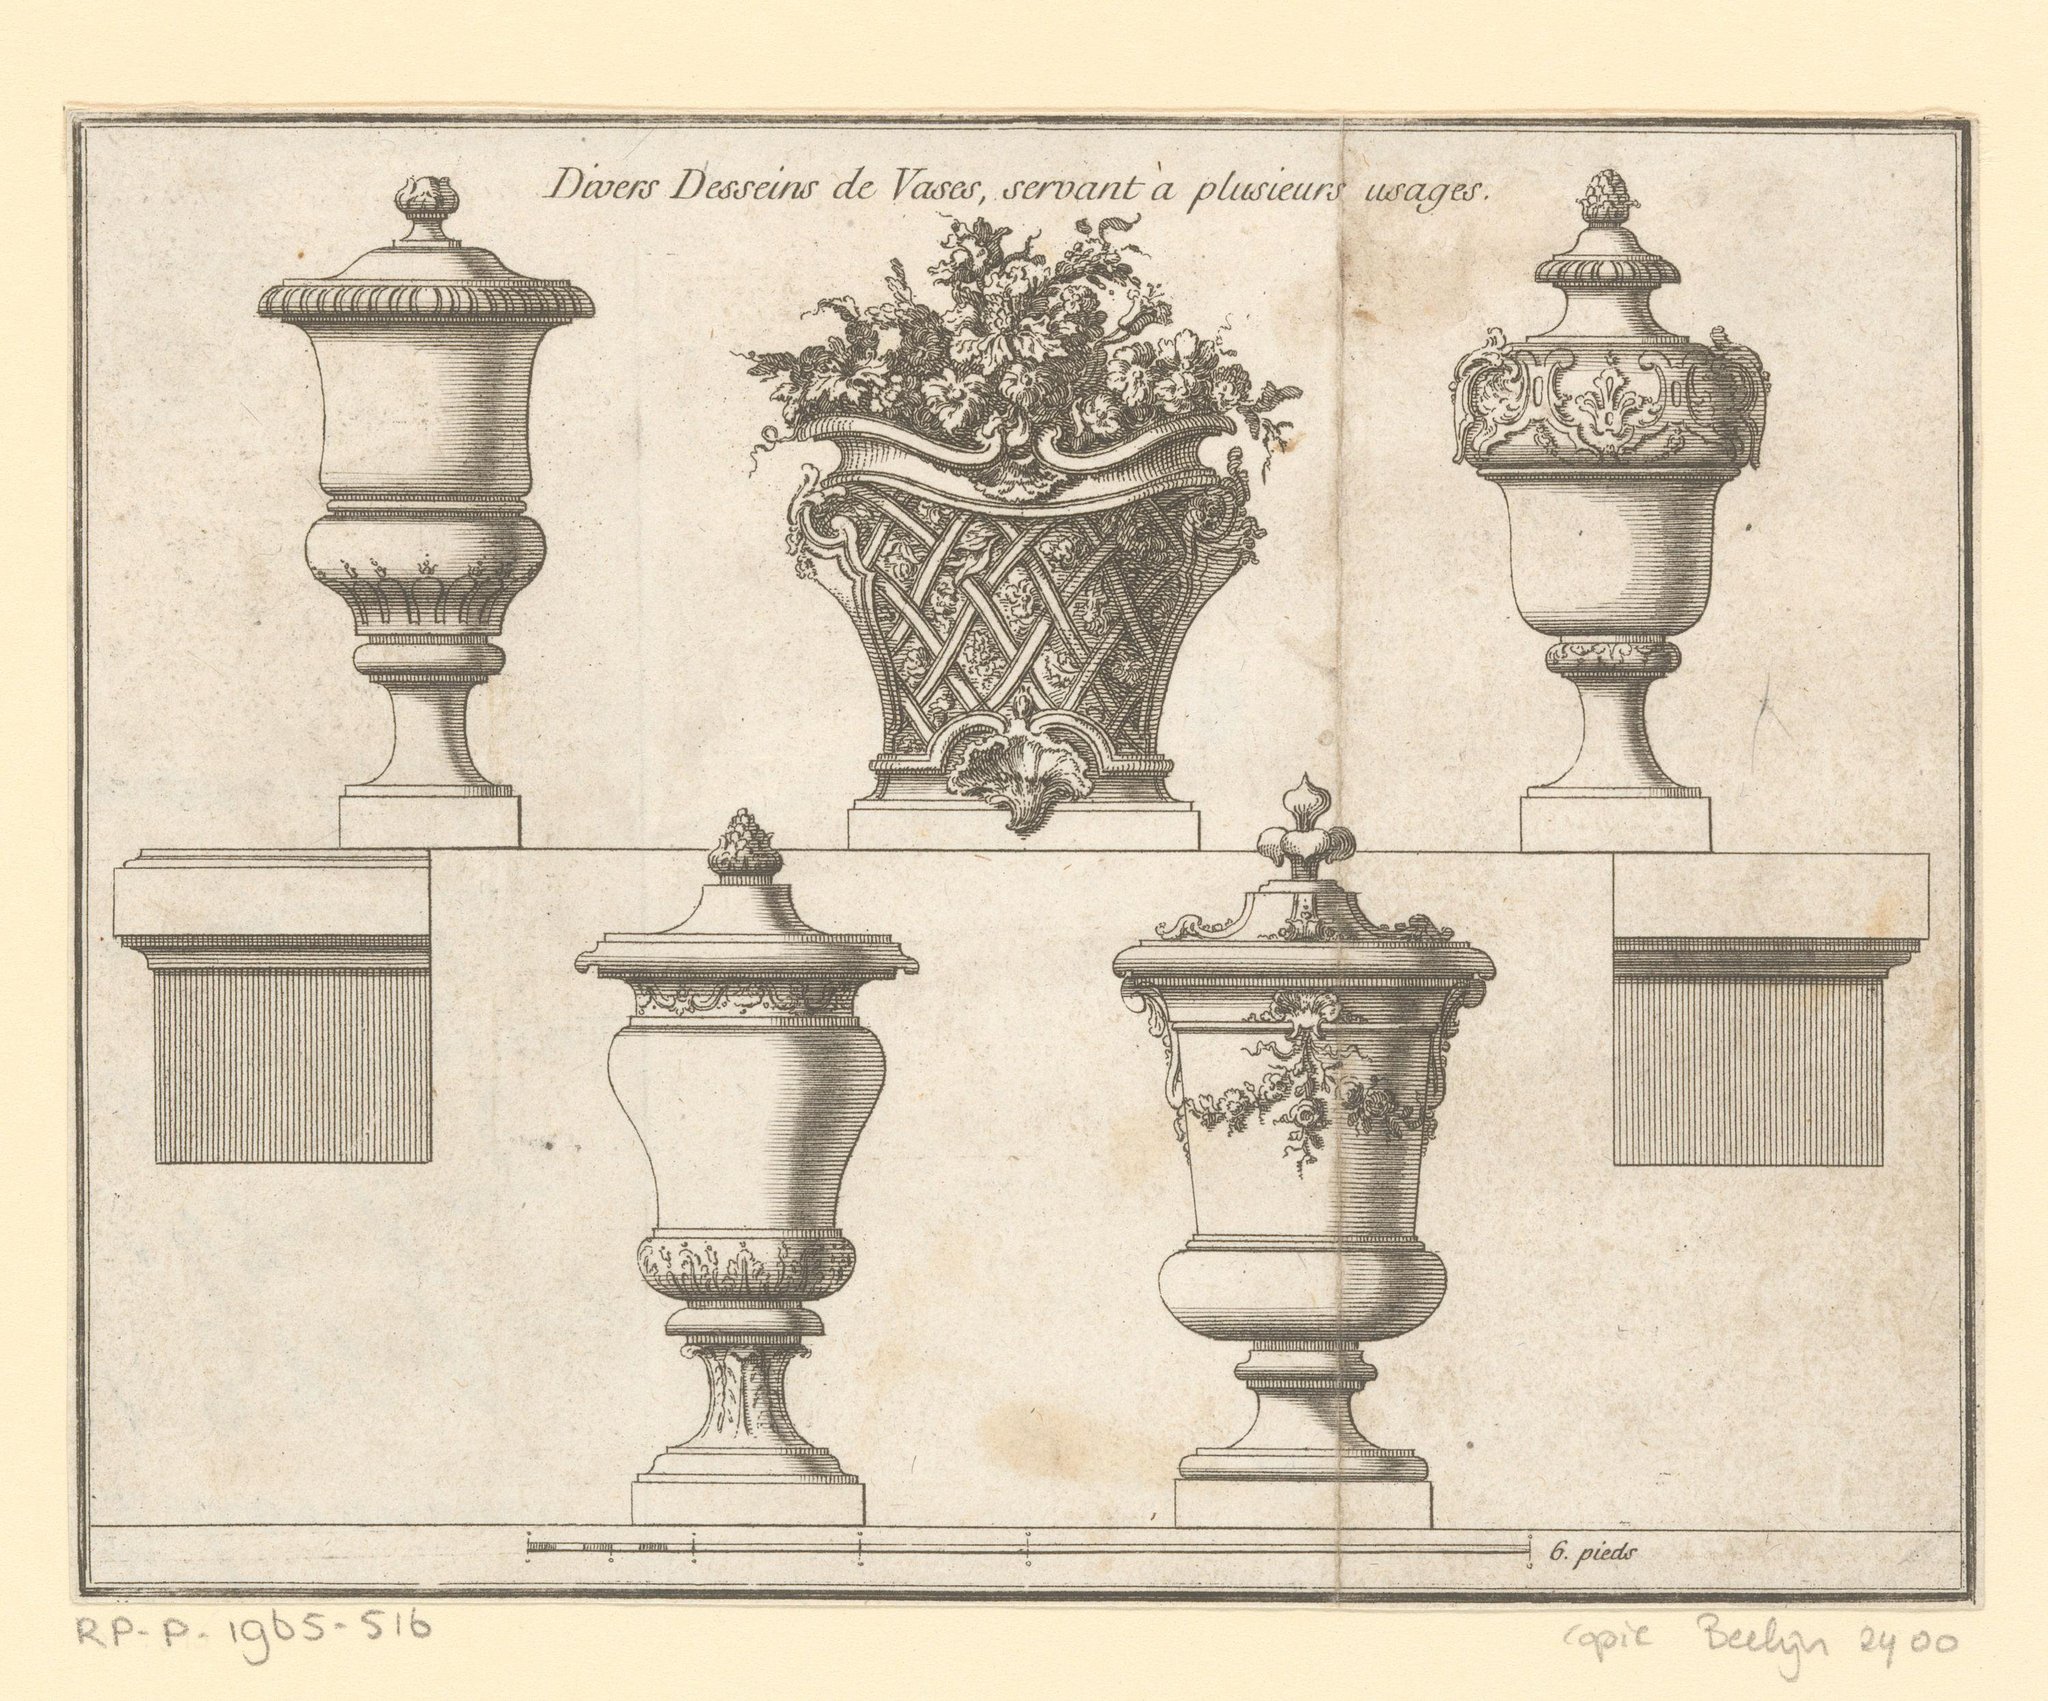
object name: print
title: Divers Desseins de Vases, servant à plusieurs usages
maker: Anonymous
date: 1738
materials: paper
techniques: engraving, etching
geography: france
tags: flowers in a vase, garden vase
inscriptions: collector's mark: Lugt 2228, collector's mark: Lugt 2760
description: Vijf geornamenteerde siervazen. De vaas midden boven met bloemen.